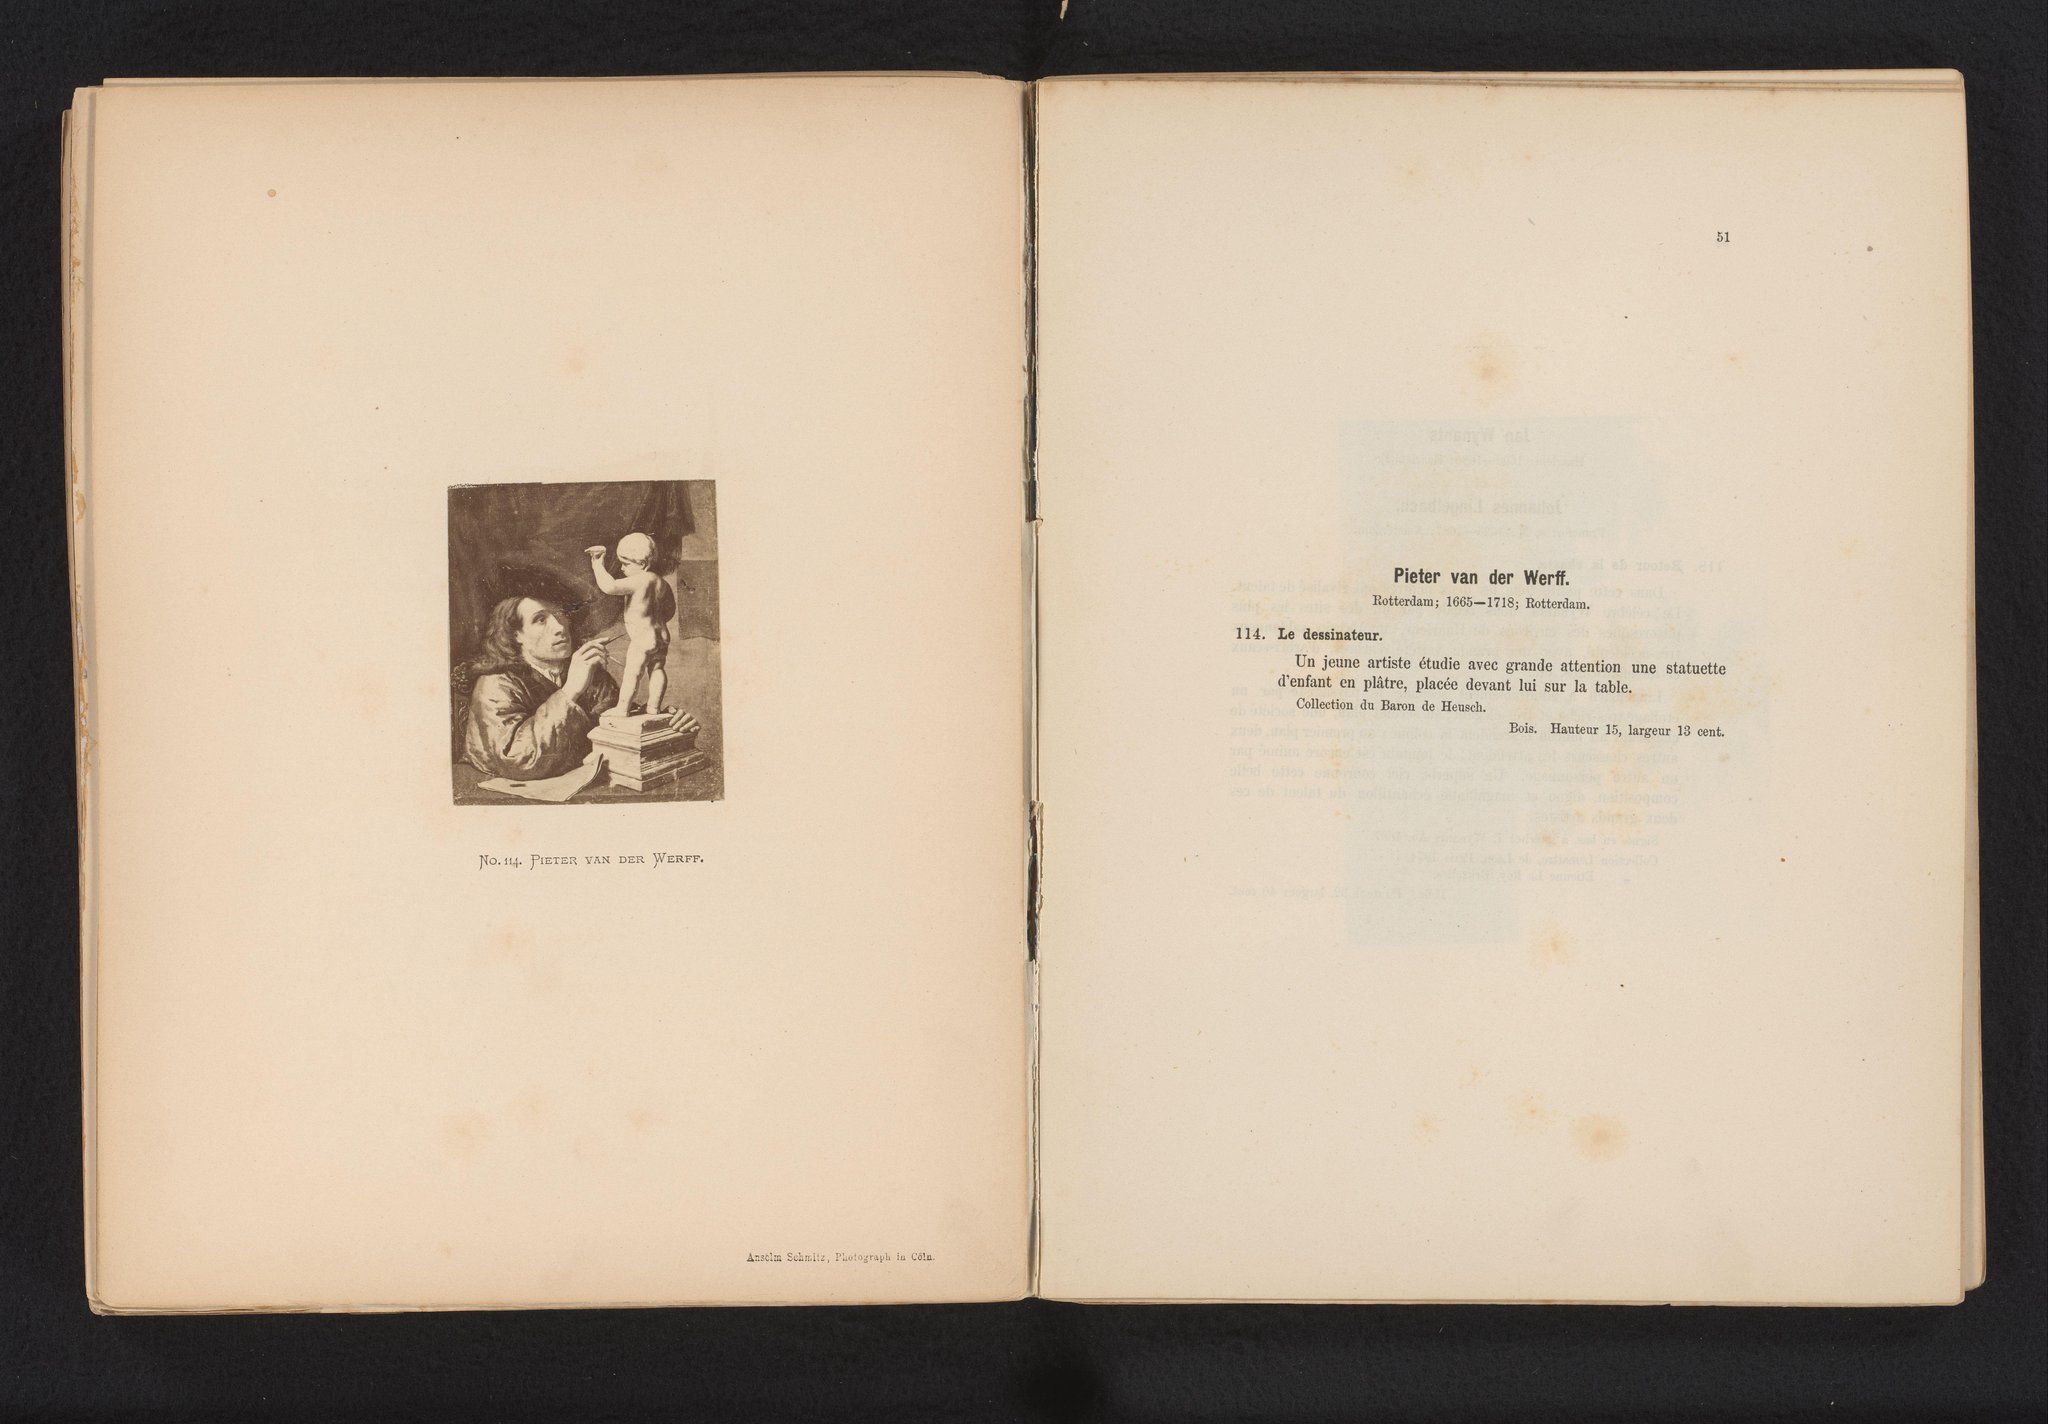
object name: reproduction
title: Fotoreproductie van een schilderij van een jonge ontwerper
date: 1871-1876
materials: photographic support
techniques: albumen print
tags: student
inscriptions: inscription: ‘No. 114. Pieter van der Werff’